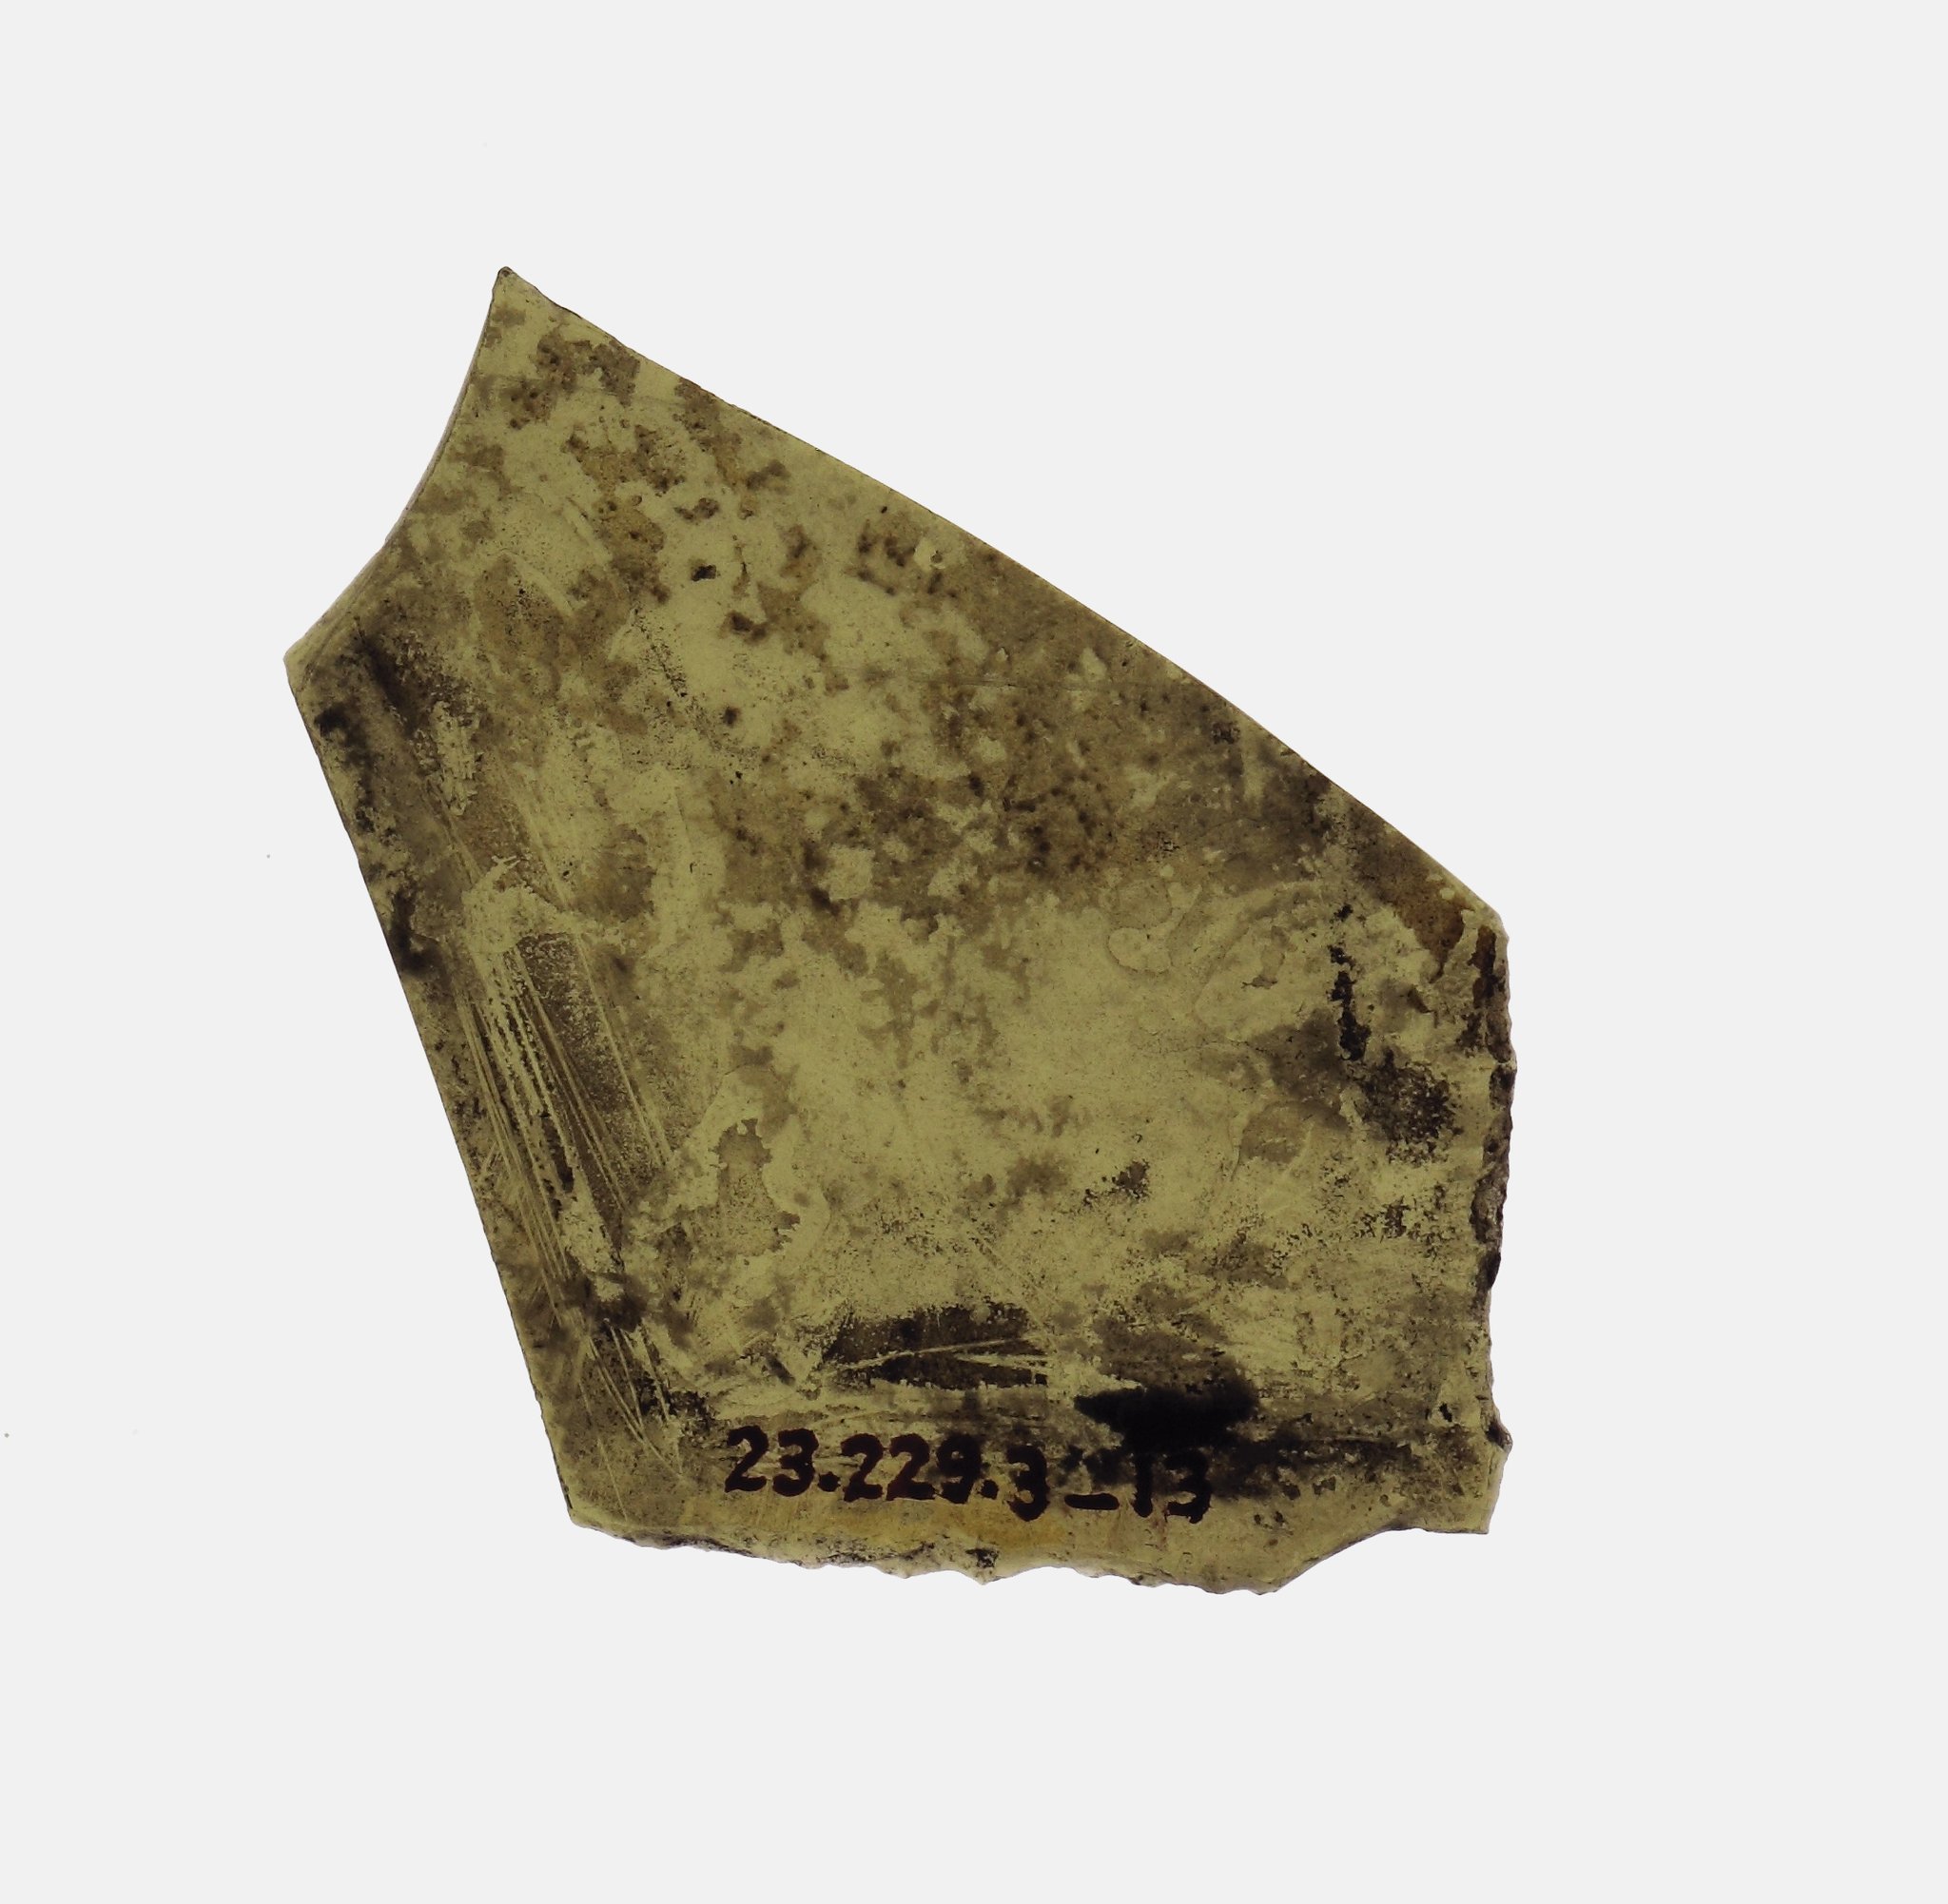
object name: fragment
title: Glass Fragment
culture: south netherlandish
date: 1601-1700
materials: glass